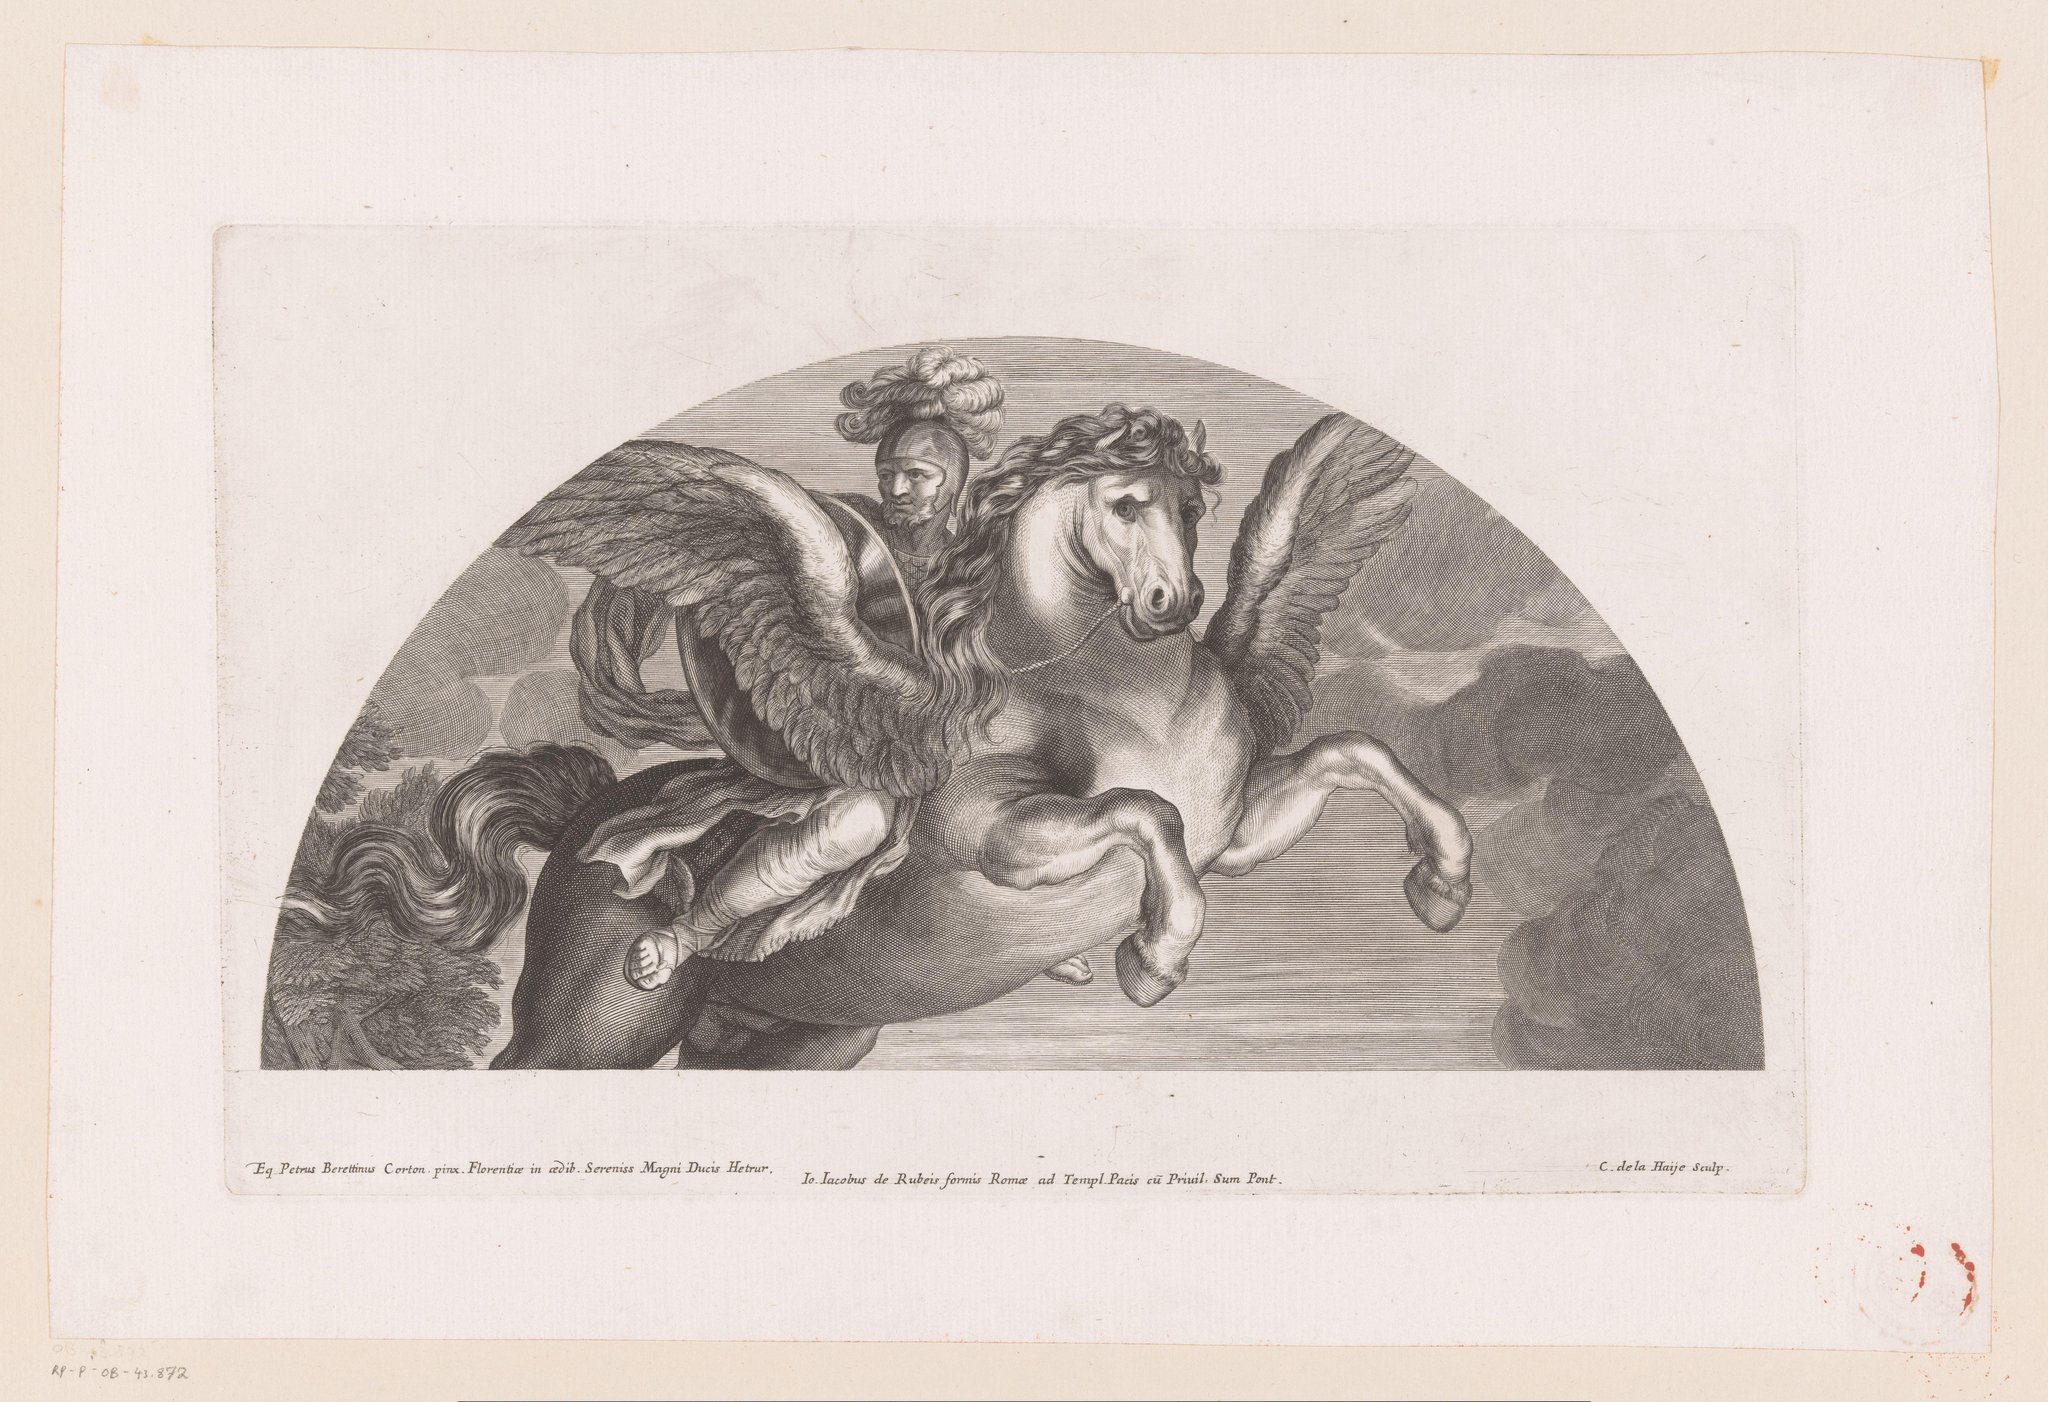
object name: print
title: Perseus op Pegasus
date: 1651-1691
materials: paper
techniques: engraving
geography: france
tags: pegasus, the winged horse, (story of) perseus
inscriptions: collector's mark: Lugt 240